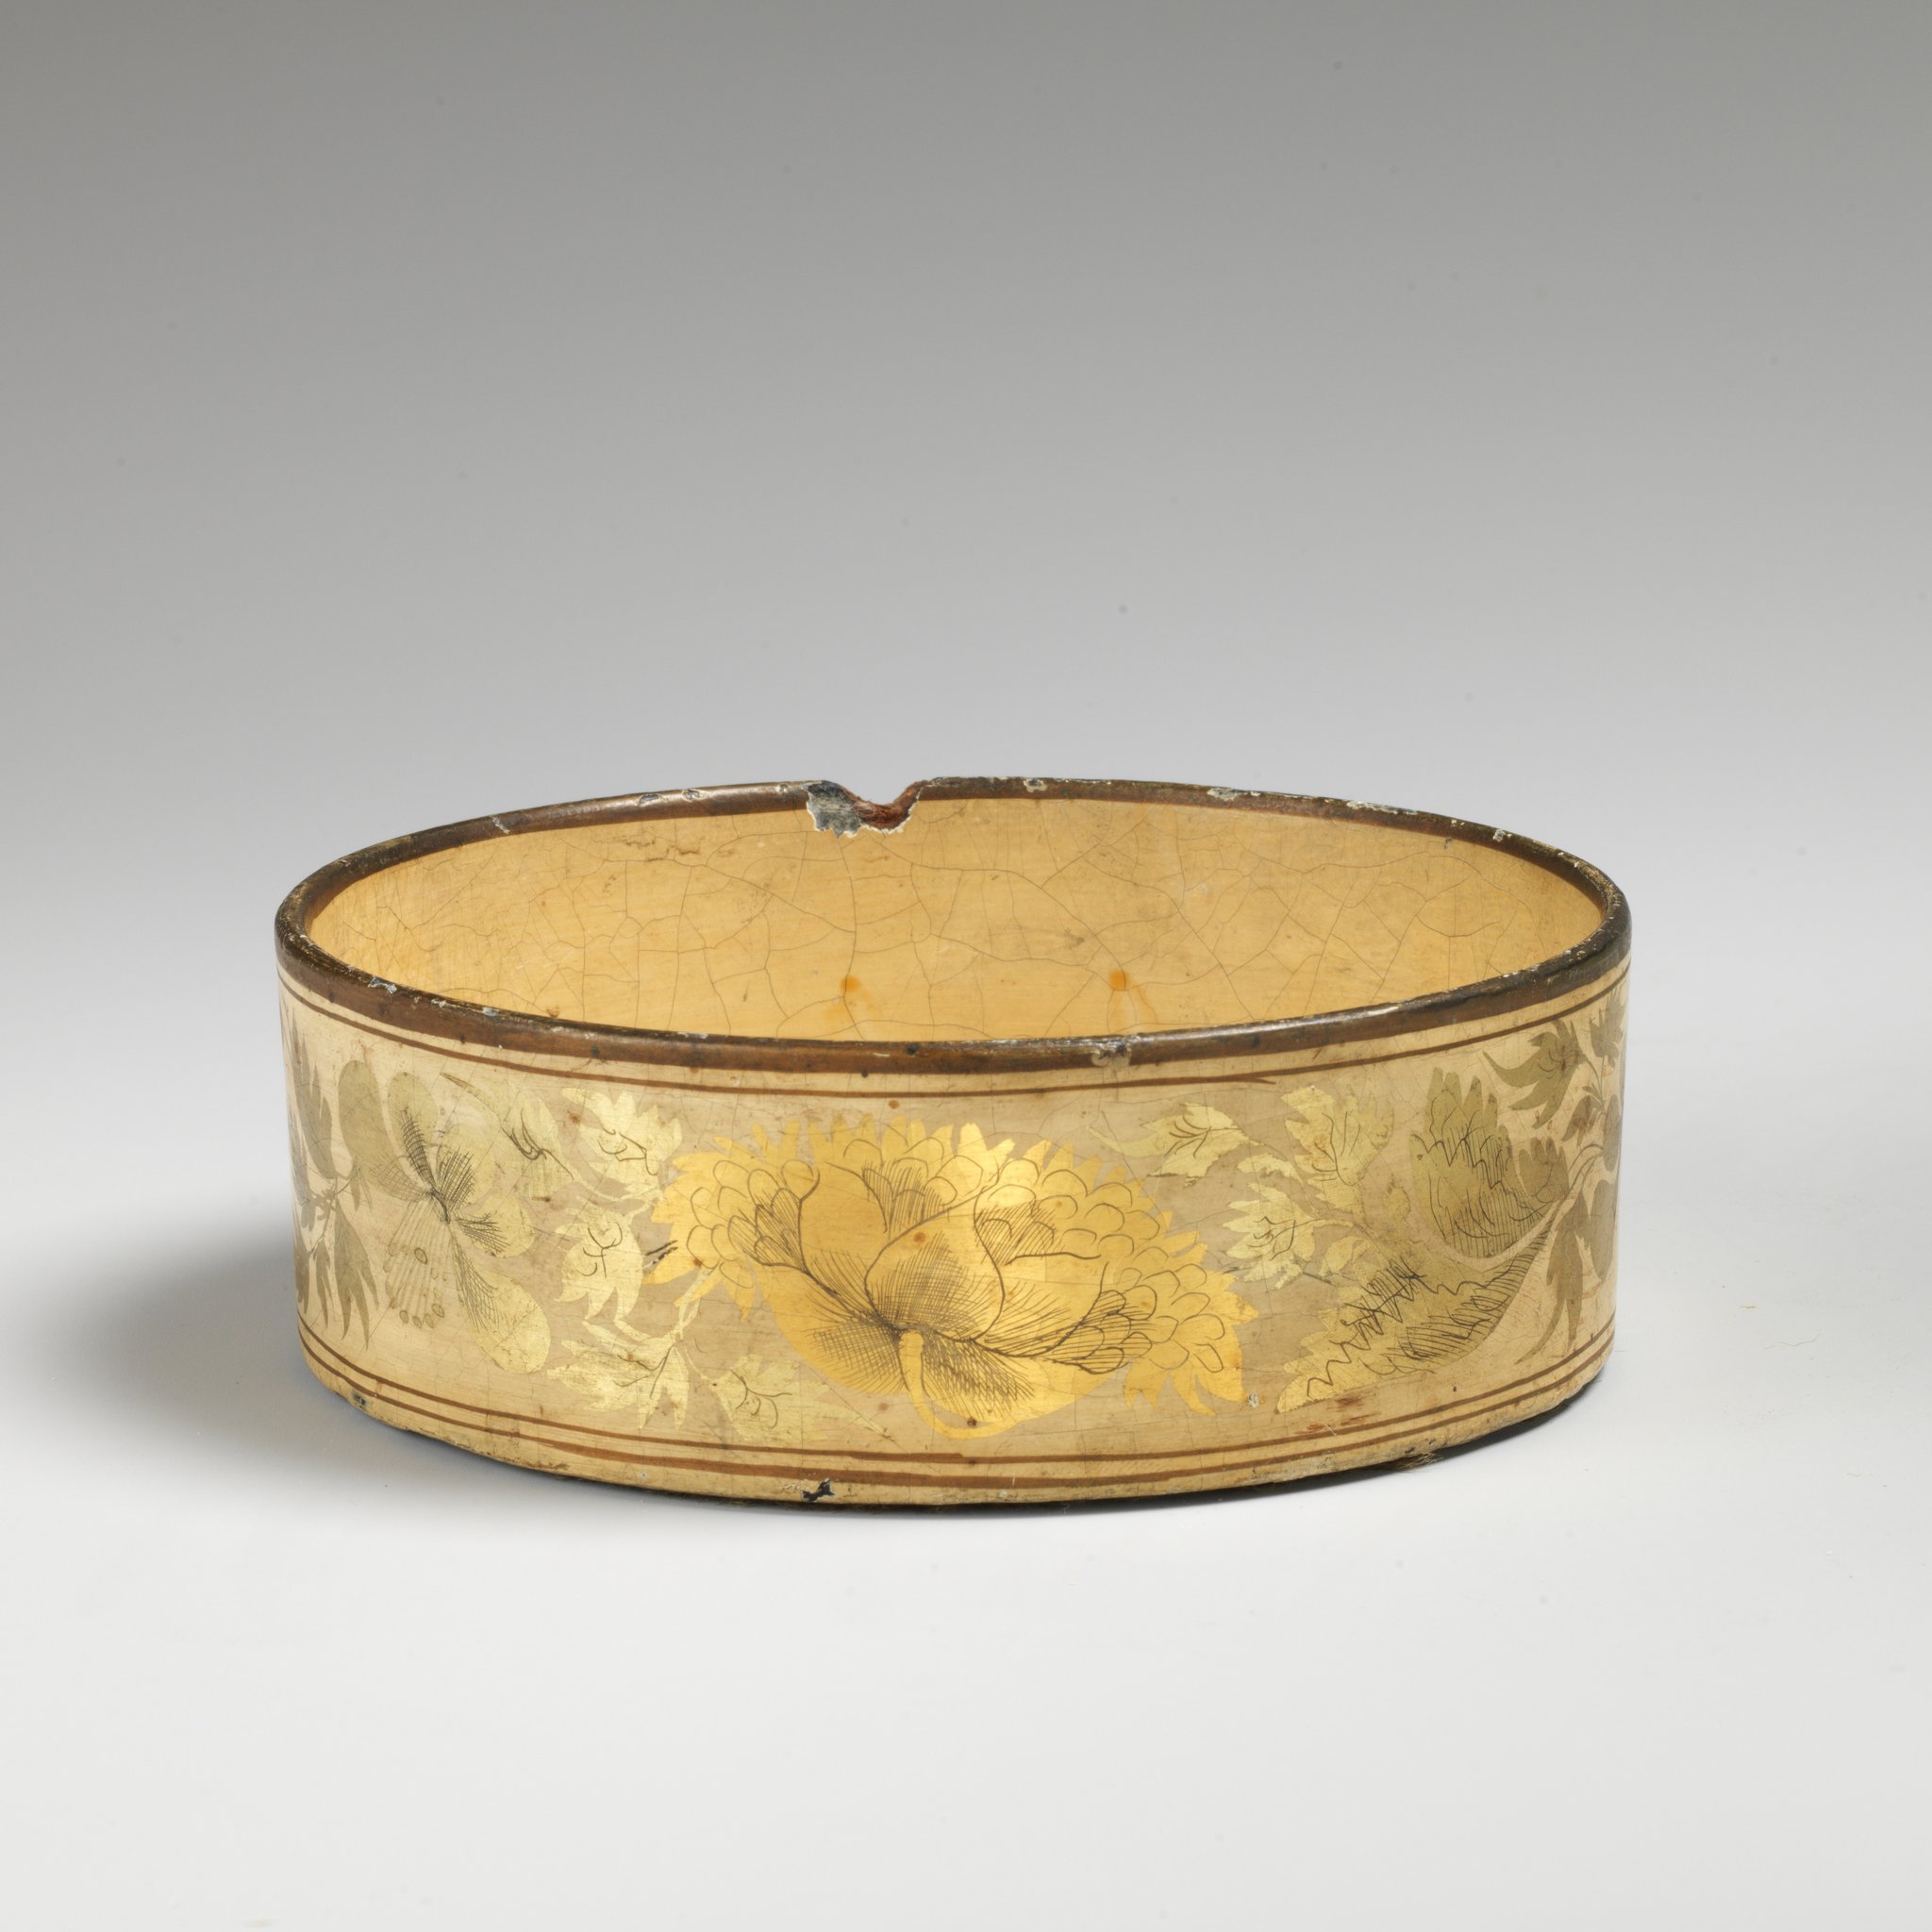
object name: coaster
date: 1701-1900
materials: lacquer